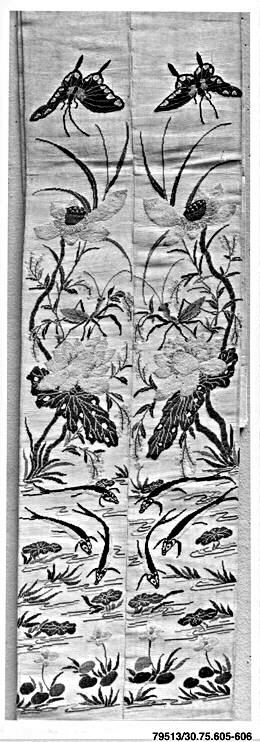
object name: sleeve band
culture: chinese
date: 1801-1900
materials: silk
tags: butterflies